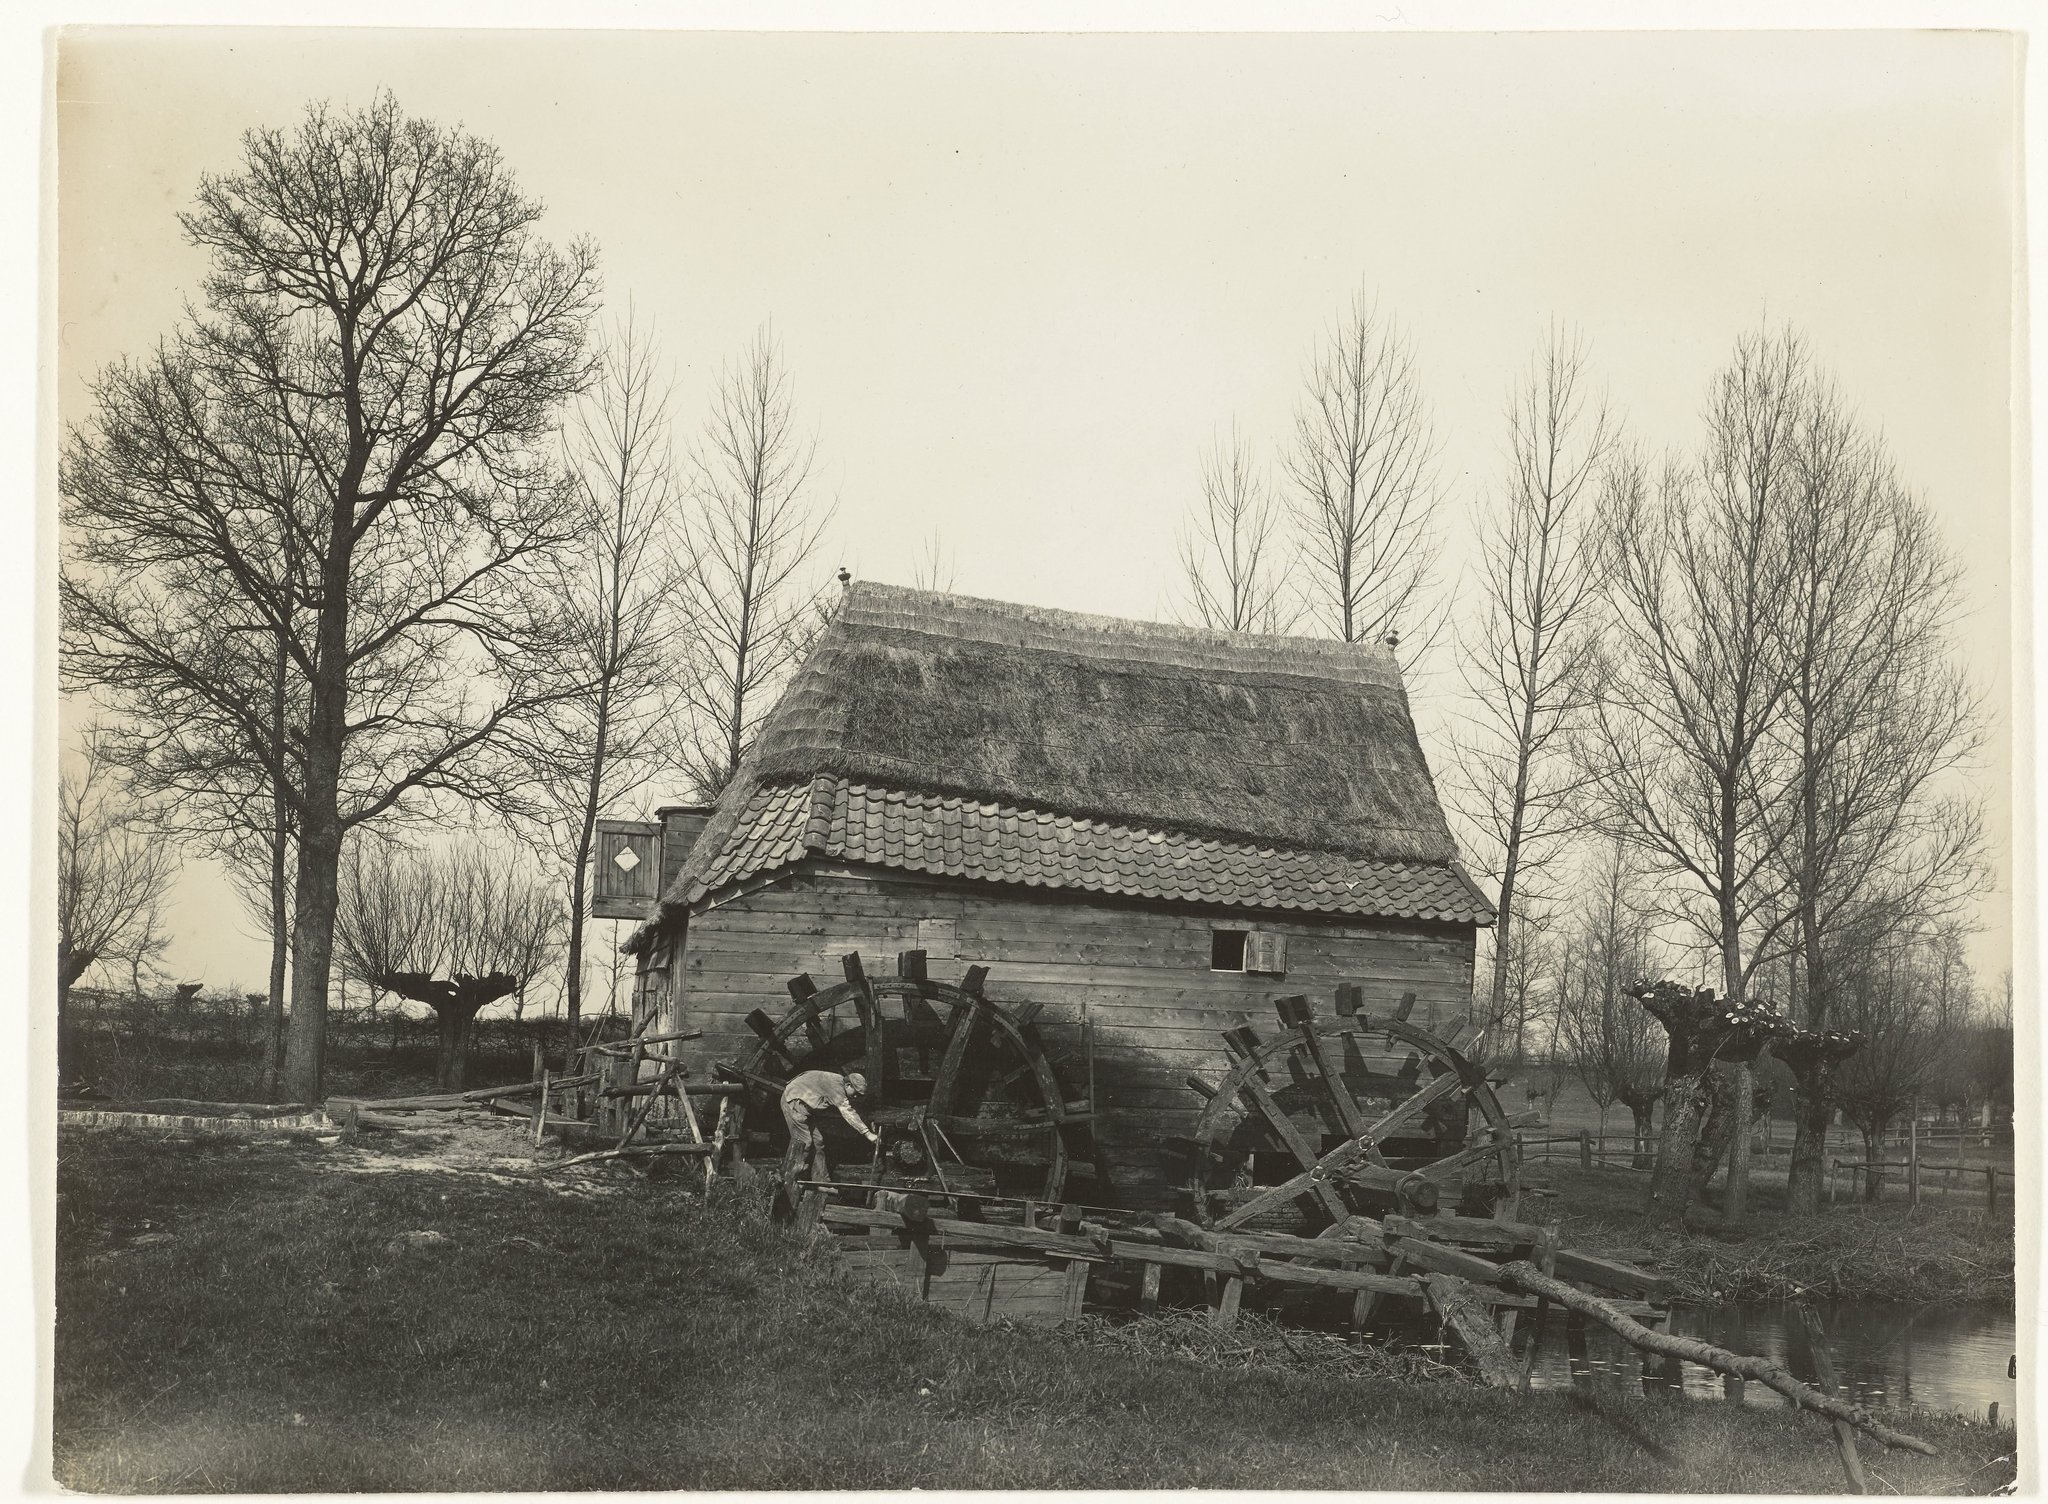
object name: photograph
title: Watermolen of Nijenbekermolen bij Voorst, Gelderland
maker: richard tepe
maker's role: fotograaf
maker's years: 1864-1952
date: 1920-1925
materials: cardboard, paper, photographic support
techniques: gelatin silver print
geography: netherlands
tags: watermill in landscape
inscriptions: mark: ‘SELO’, annotation: ‘Oude niet meer / bestaande Watermolen / te Voorst’, signature: ‘foto / R Tepe’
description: Molenaar G.J. (Geurt) van Neck aan het werk bij de watermolen.